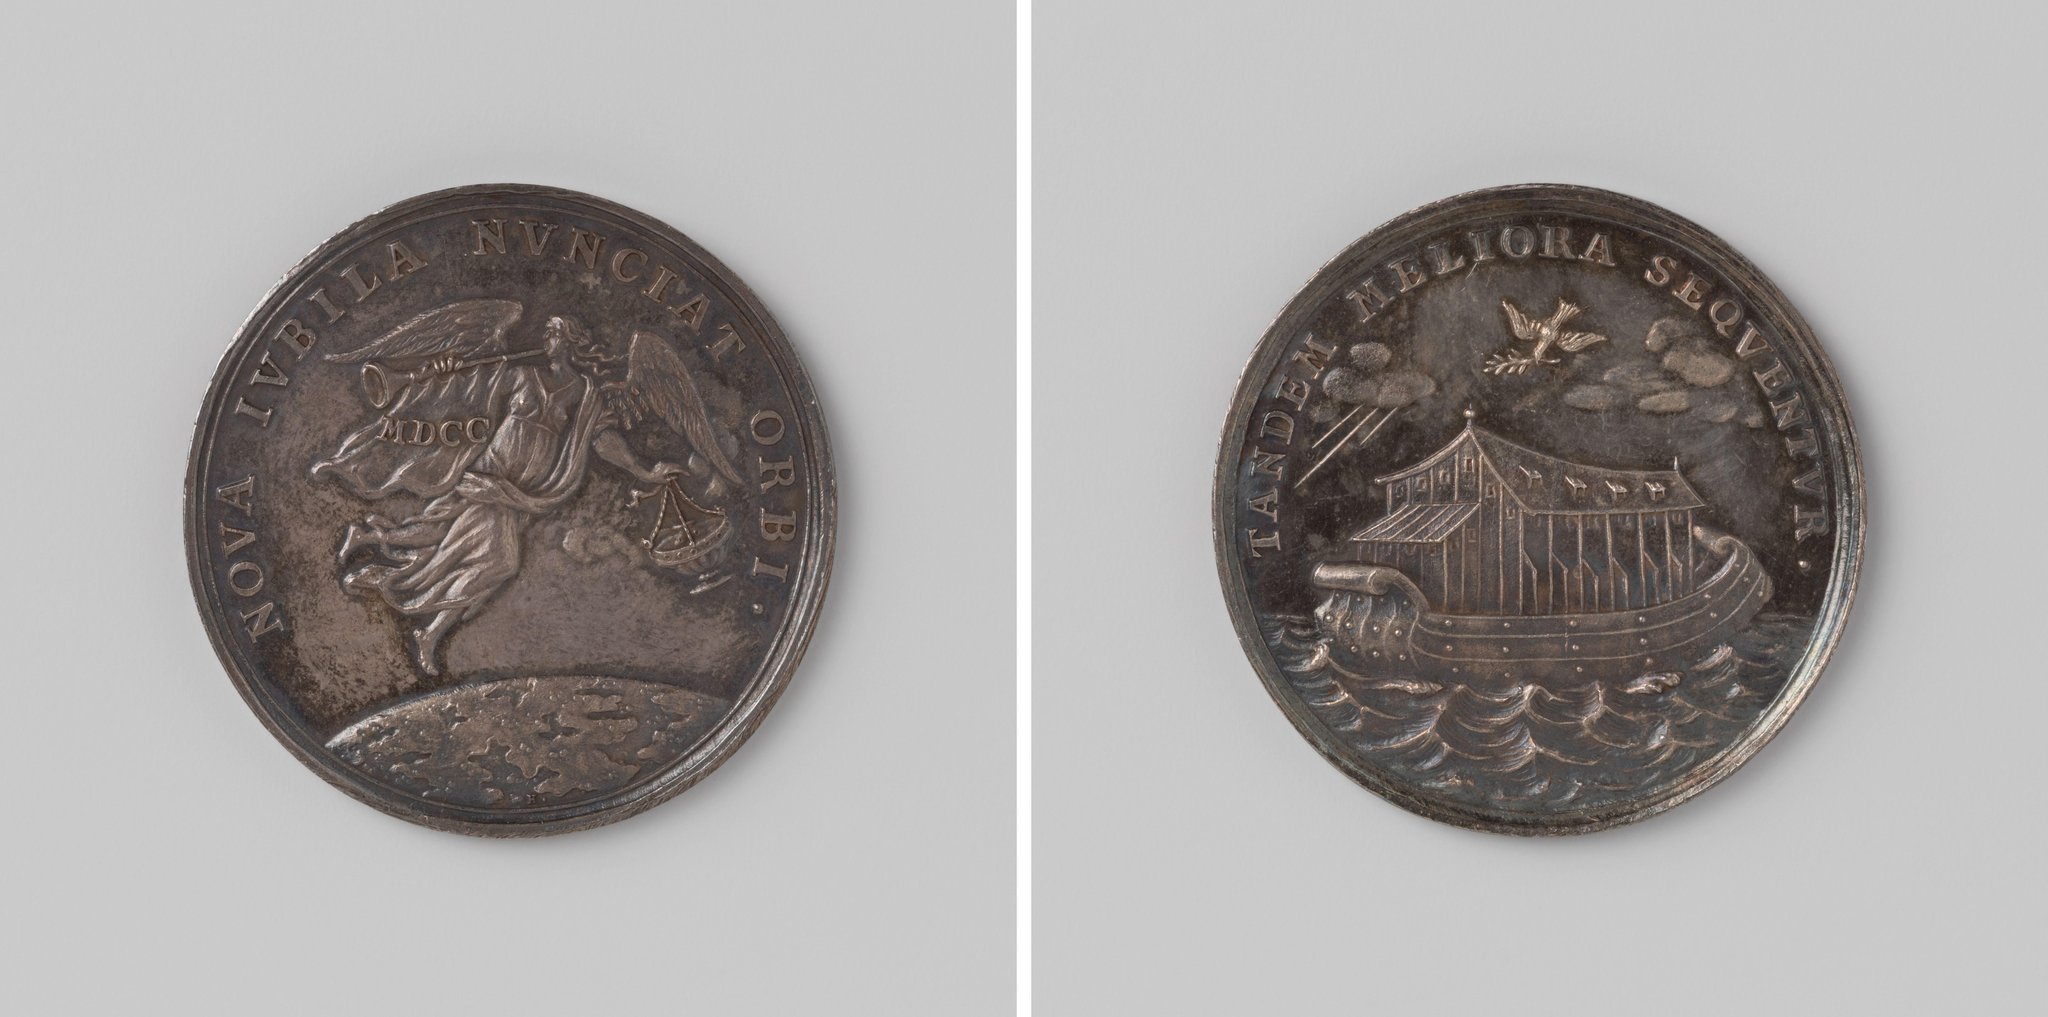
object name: history medal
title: Aanvang van de 18de eeuw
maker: Anonymous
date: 1700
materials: bronze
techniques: striking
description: Bronzen penning. Voorzijde: engel met bazuin en wierrookvat vliegt boven wereld binnen omschrift. Keerzijde: Ark van Noach met daarboven duif met olijftak in bek binnen omschrift